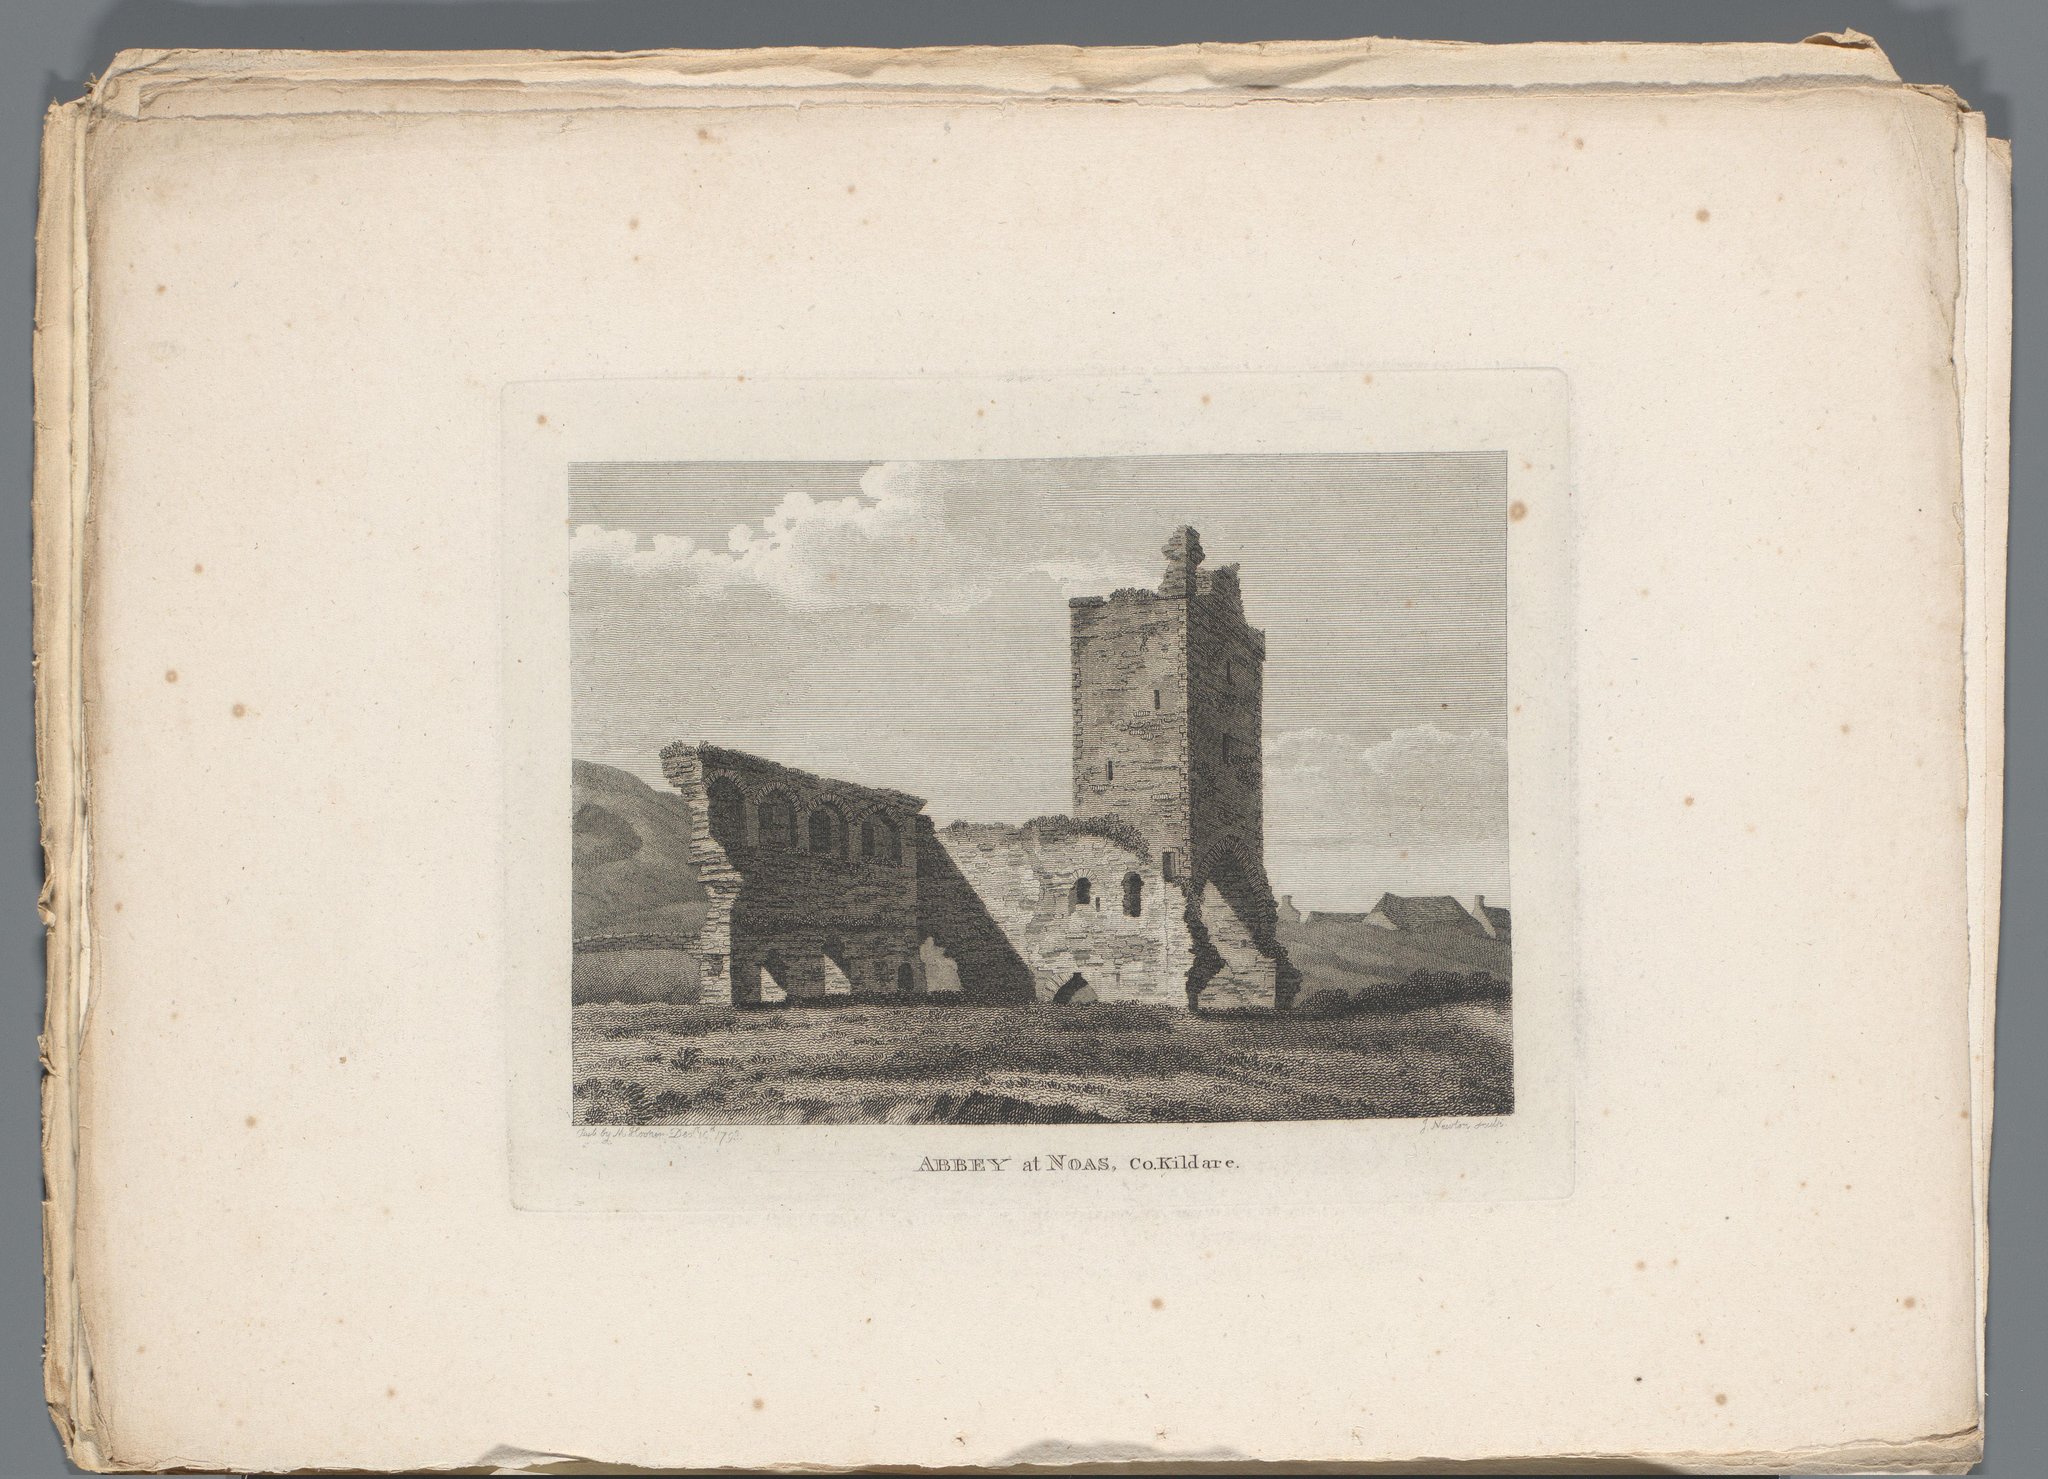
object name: print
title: Abbey at Noas, Co.Kildare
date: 1793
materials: paper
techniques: etching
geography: london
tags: abbey, monastery, convent ~ roman catholic church, landscape with ruins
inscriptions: date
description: Prent verschenen in: Grose, Francis. The antiquities of Ireland, dl. 2. Londen: S. Hooper, 1795.